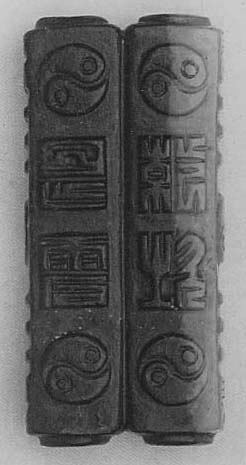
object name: signet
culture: chinese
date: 1902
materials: jade